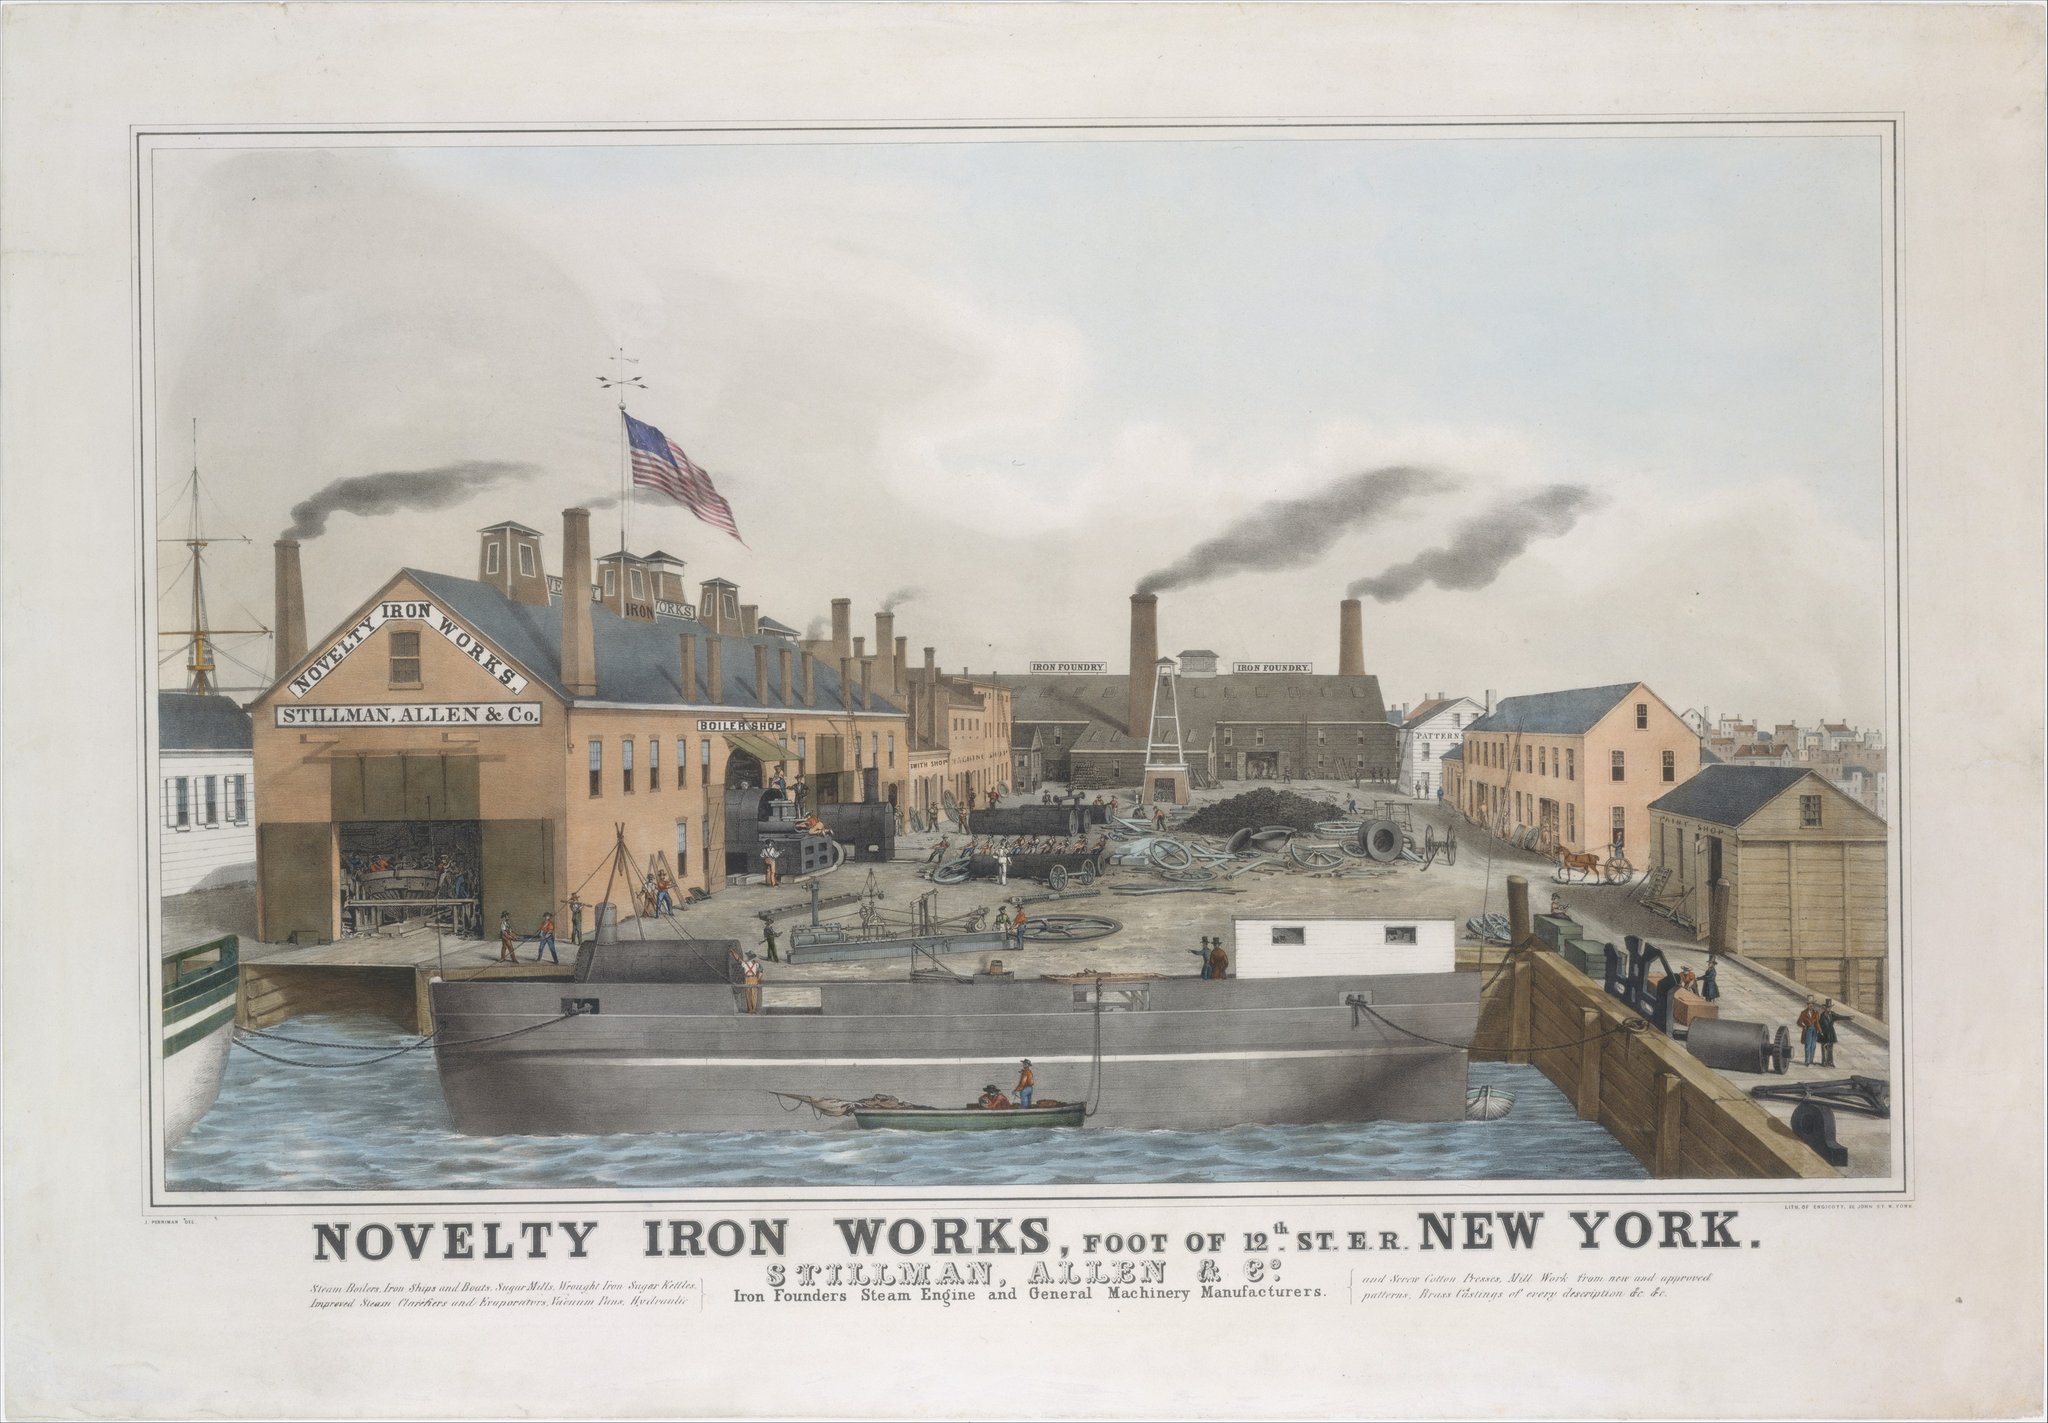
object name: print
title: Novelty Iron works, Foot of 12th St. E.R. New York. Stillman, Allen & Co., Iron Founders, Steam Engine and General Machinery Manufacturers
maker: john penniman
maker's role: artist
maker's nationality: american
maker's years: 1817-1850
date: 1842-1855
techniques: hand coloring, lithograph, printing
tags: factories,boats,new york city